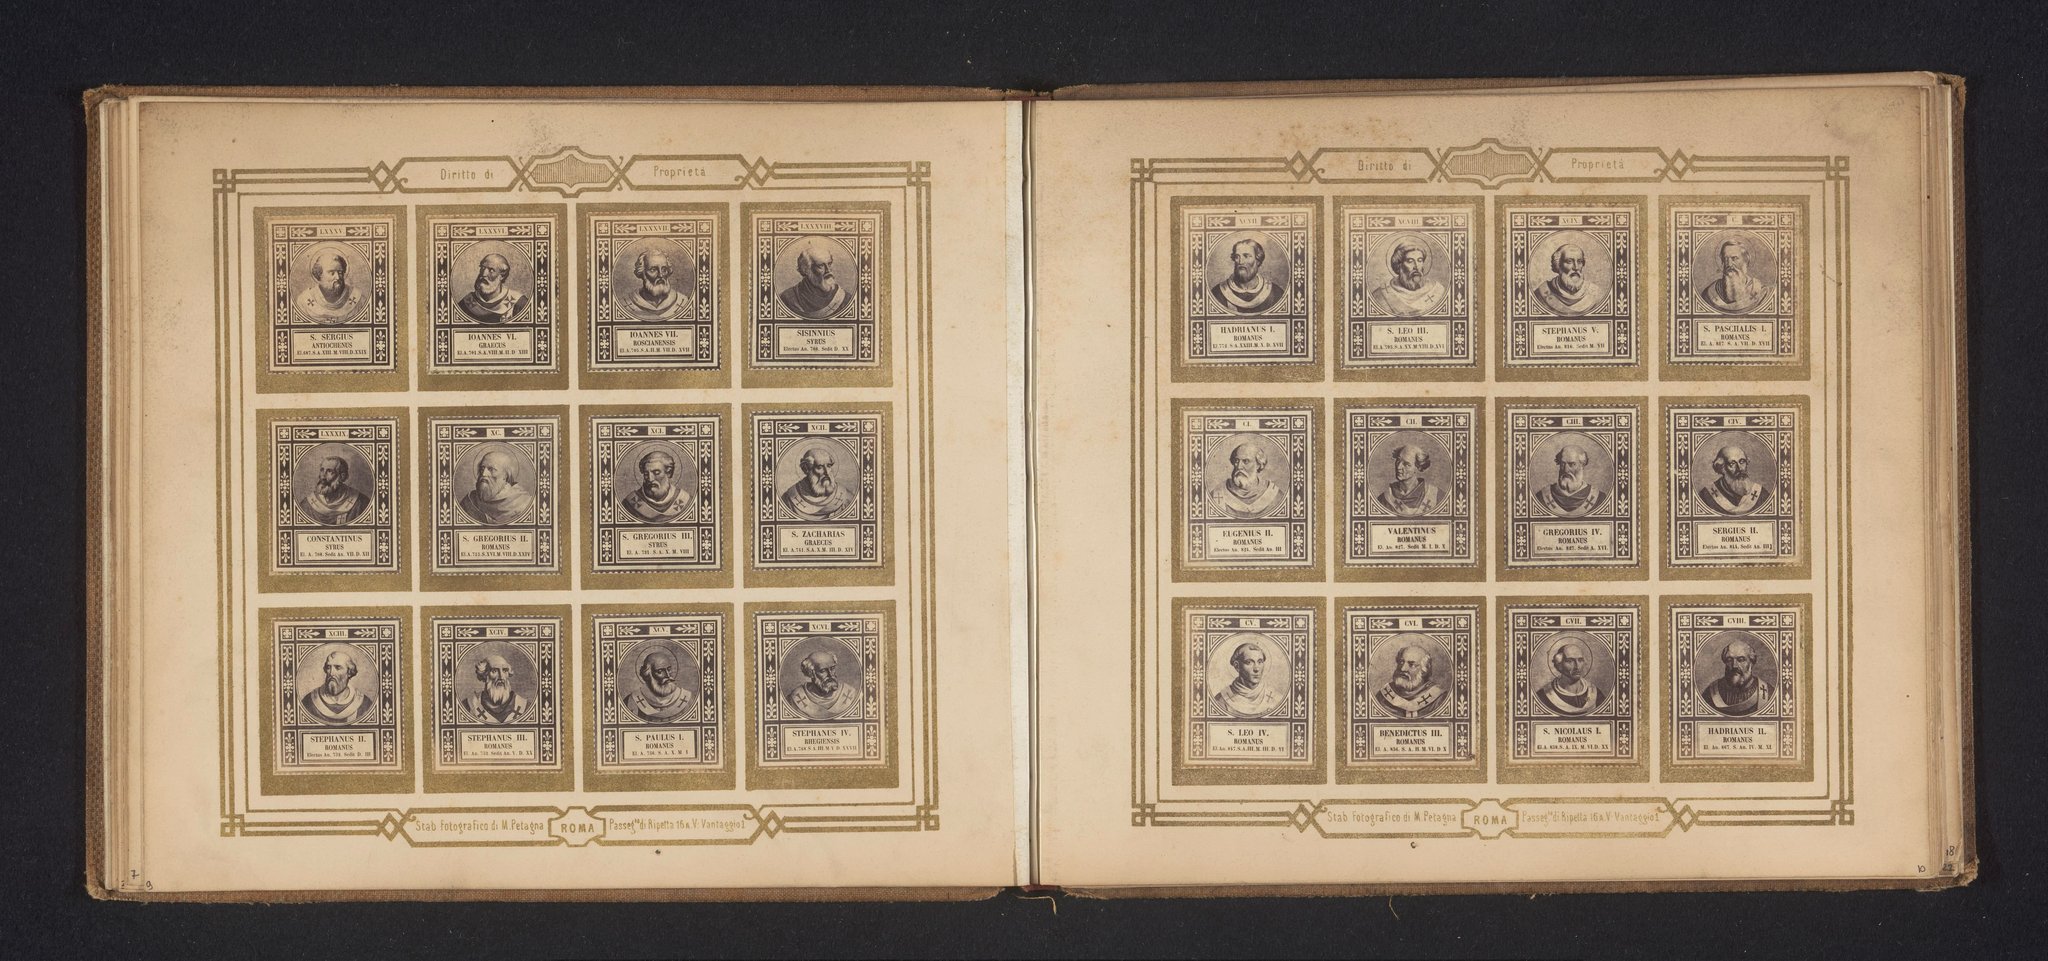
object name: page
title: Fotoreproductie van twaalf portretten van pausen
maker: m. petagna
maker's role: fotograaf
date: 1854-1864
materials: photographic support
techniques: albumen print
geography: rome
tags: pope